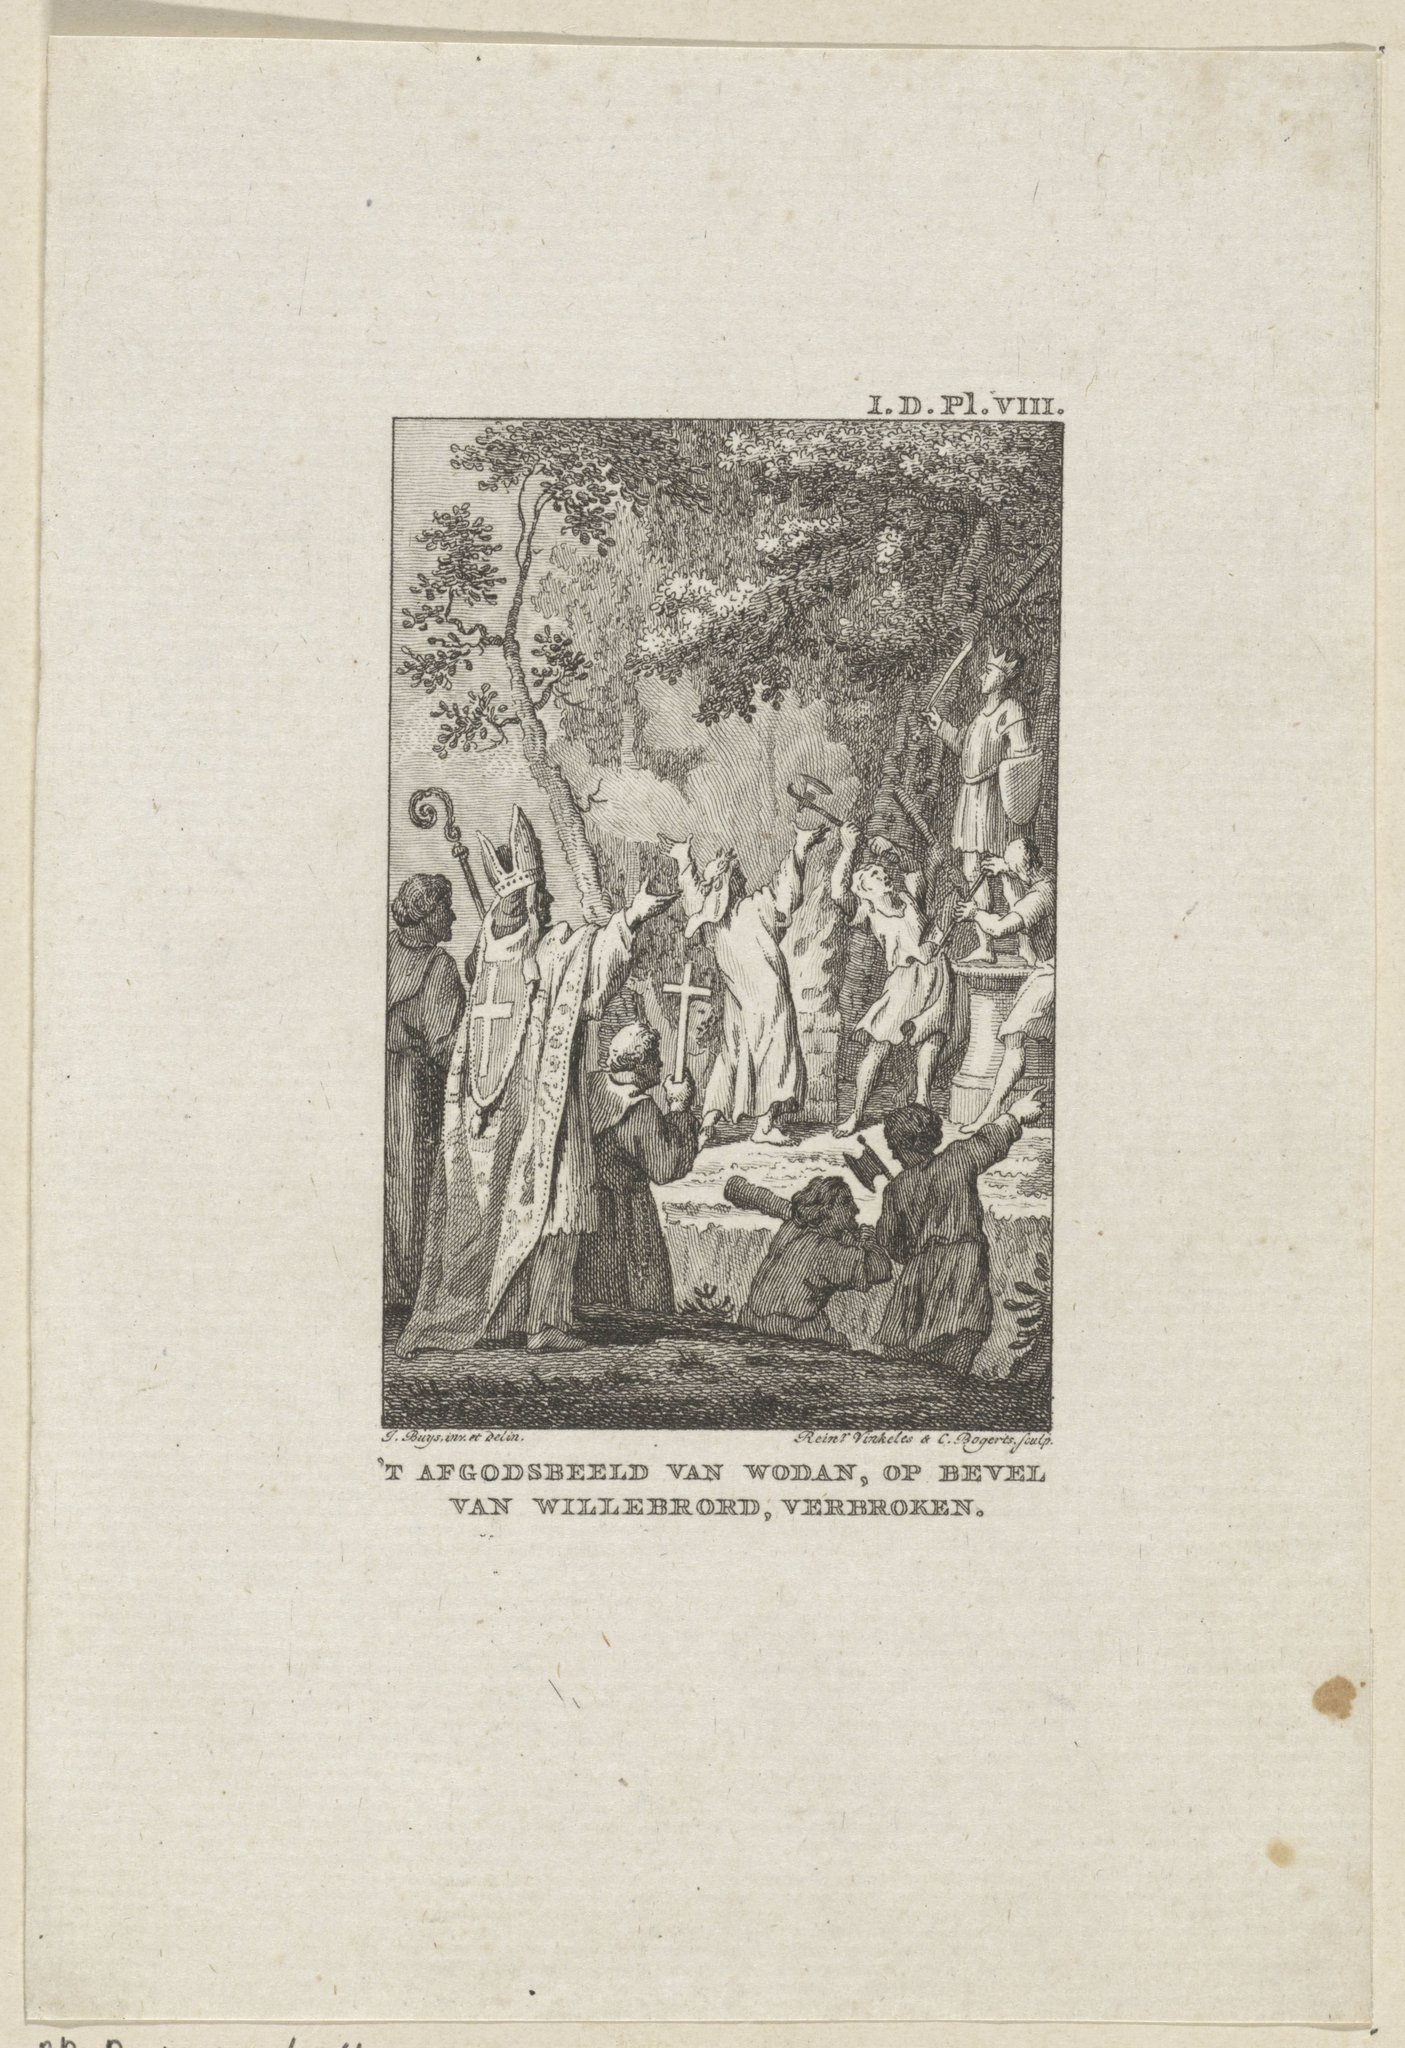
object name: history print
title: 'T afgodsbeeld van Wodan, op bevel van Willibrord, verbroken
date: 1783-1795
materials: paper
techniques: etching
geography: amsterdam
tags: st. willibrord breaking the pagan idols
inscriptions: collector's mark: Lugt 2228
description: Illustratie voor: J. Fokke. Geschiedenissen der Vereenigde Nederlanden voor de vaderlandsche jeugd. Amsterdam: Johannes Allart, 1783-1795, 25 delen, dl. I, pl. VIII.